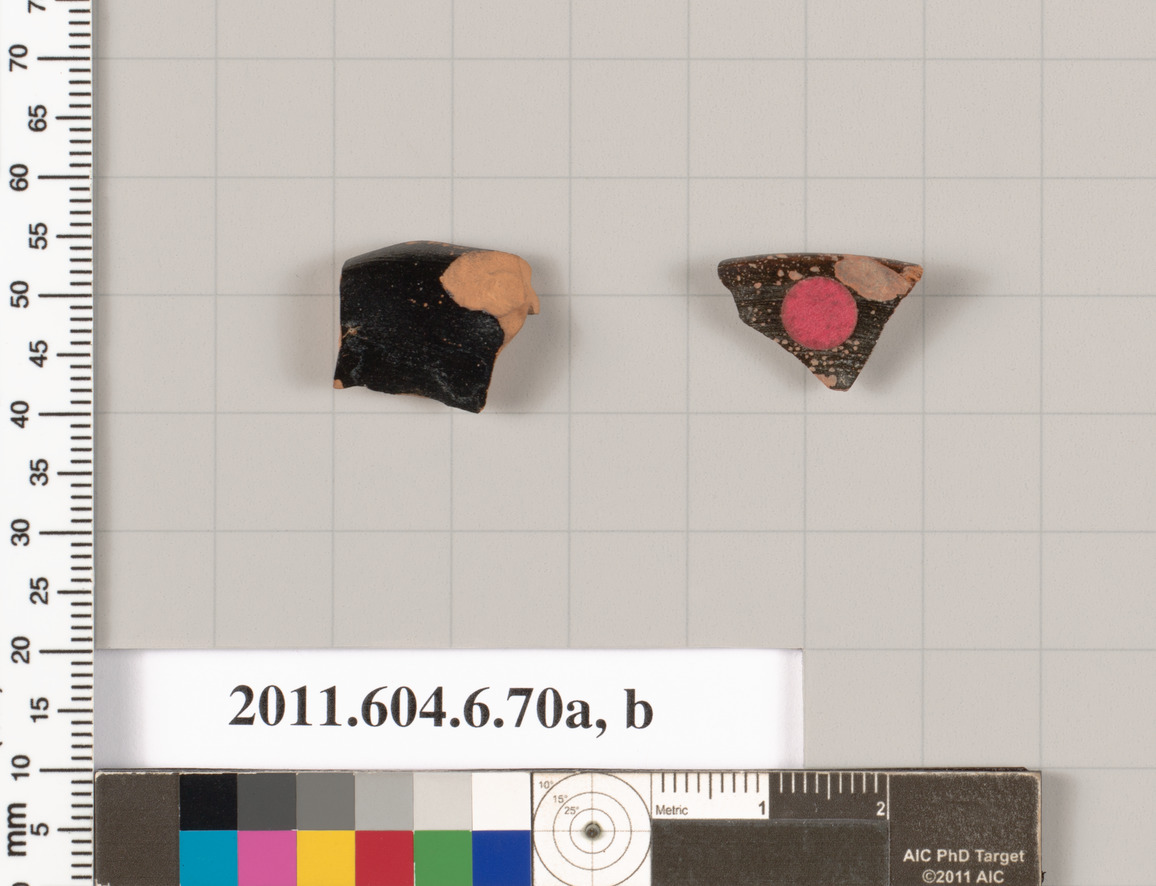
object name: undetermined shape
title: Terracotta fragments of undetermined shapes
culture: greek, attic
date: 600-401 BCE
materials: terracotta